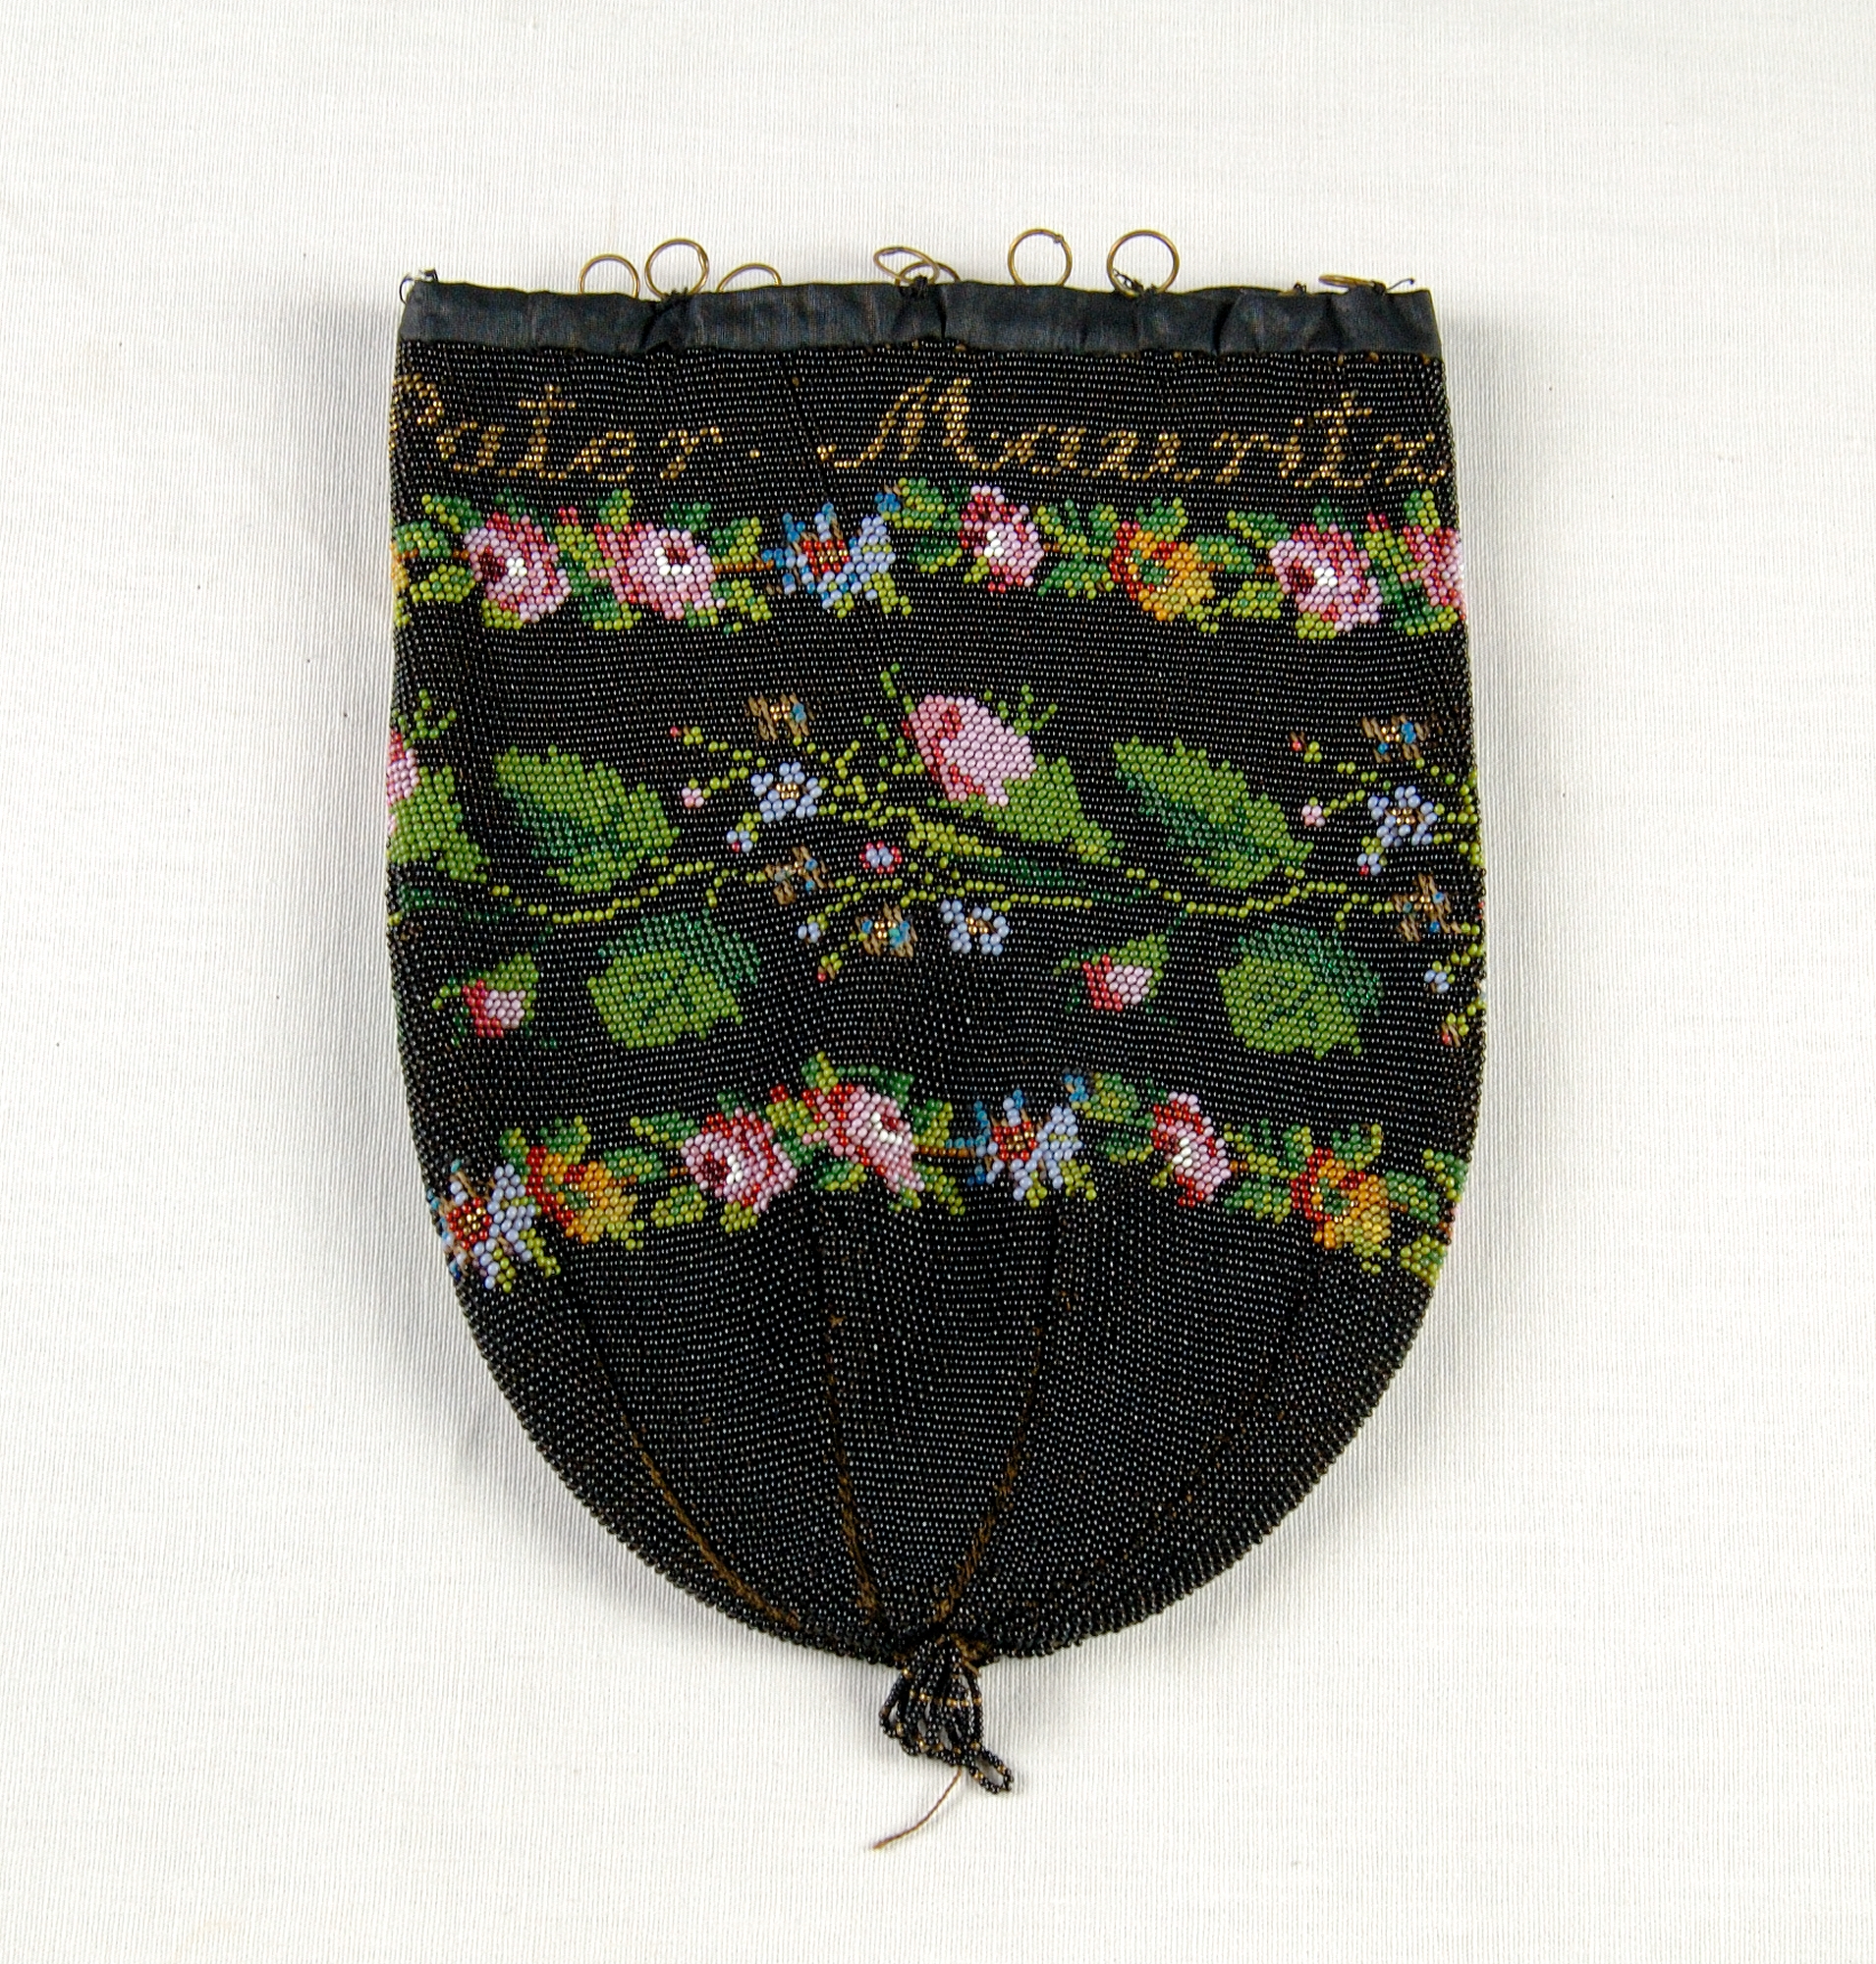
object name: pouch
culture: american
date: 1840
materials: glass, leather, metal, silk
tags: flowers